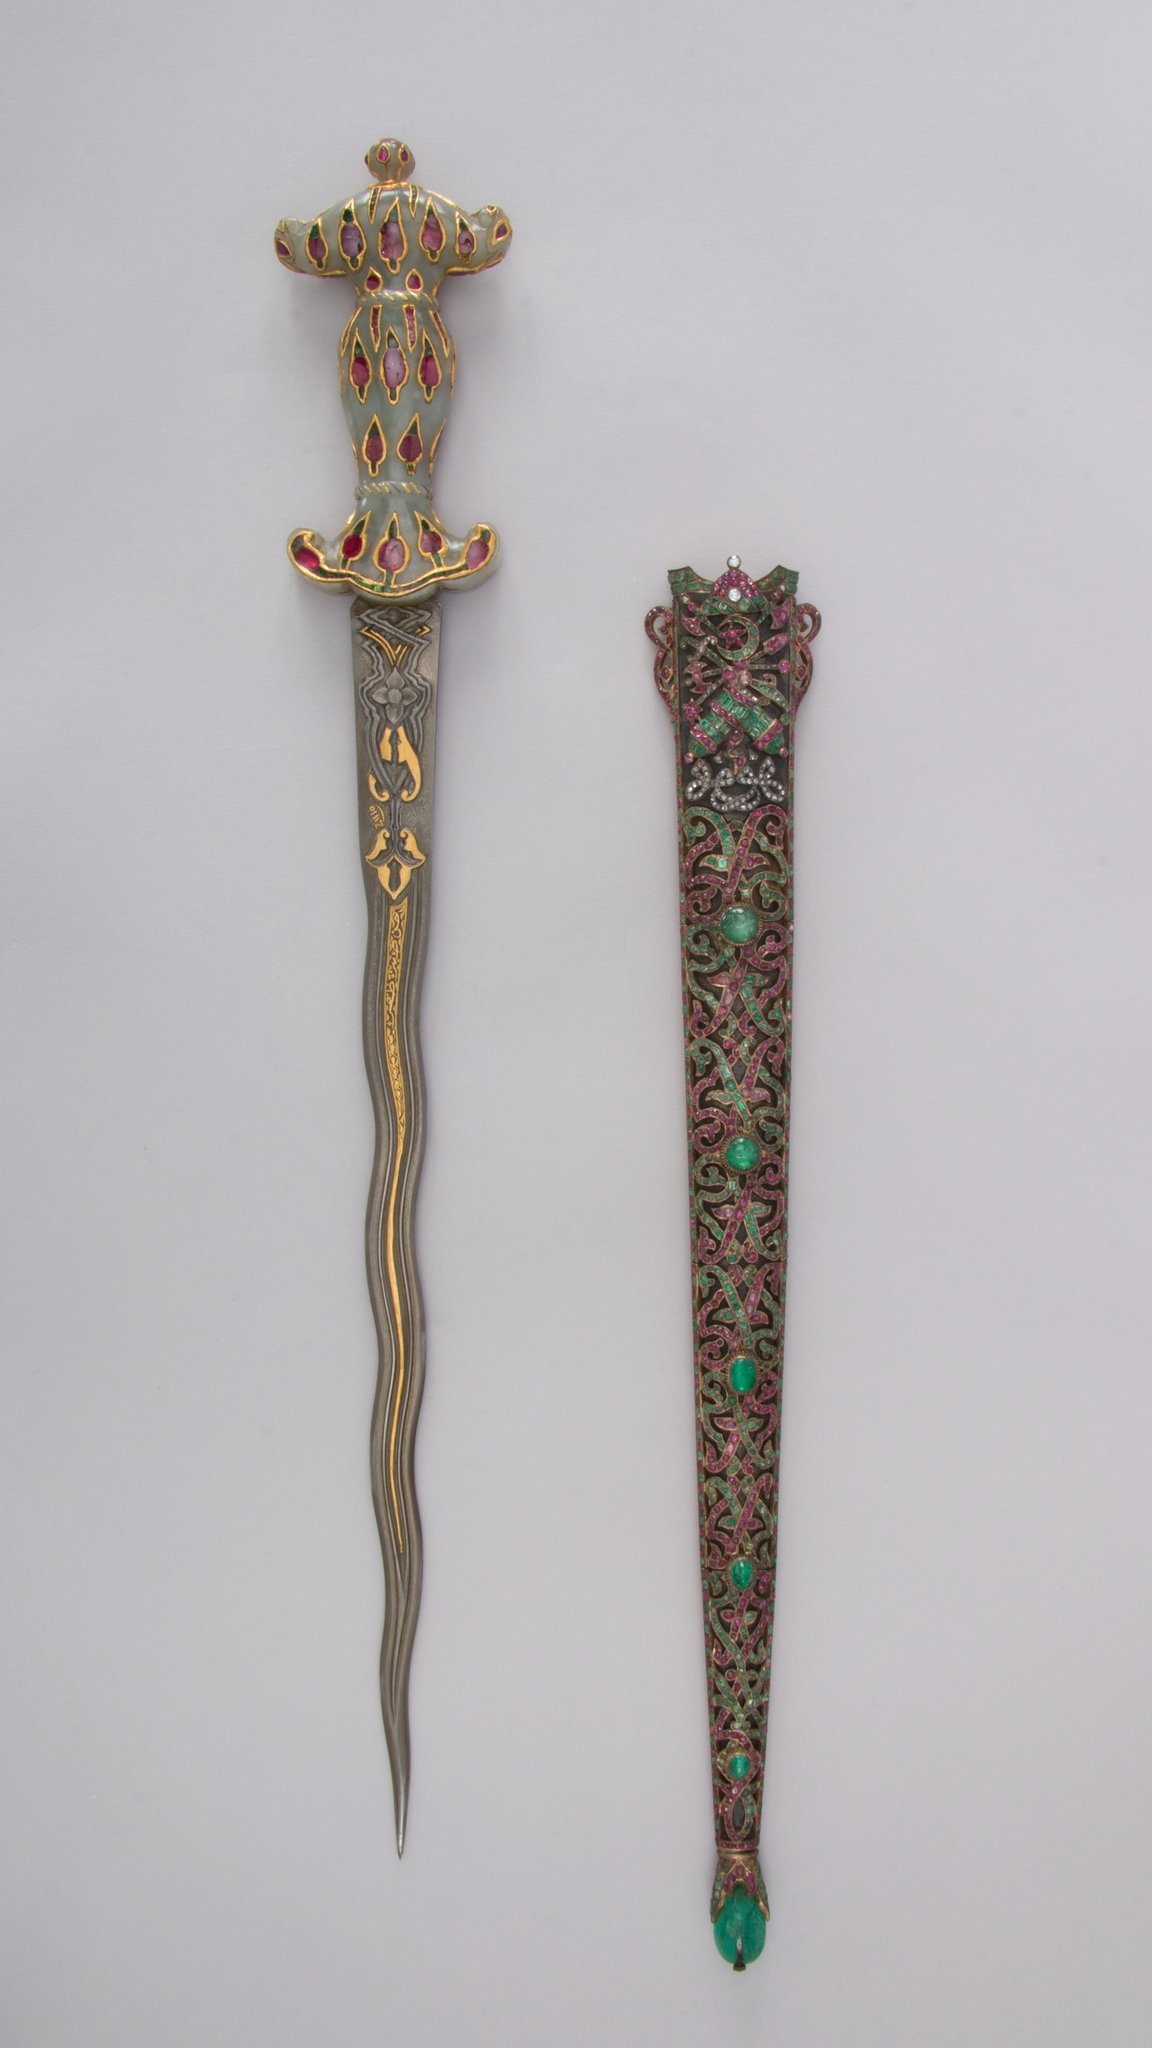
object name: dagger with sheath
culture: turkish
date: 1801-1900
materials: diamond, gemstone, gold, jade, steel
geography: ottoman empire